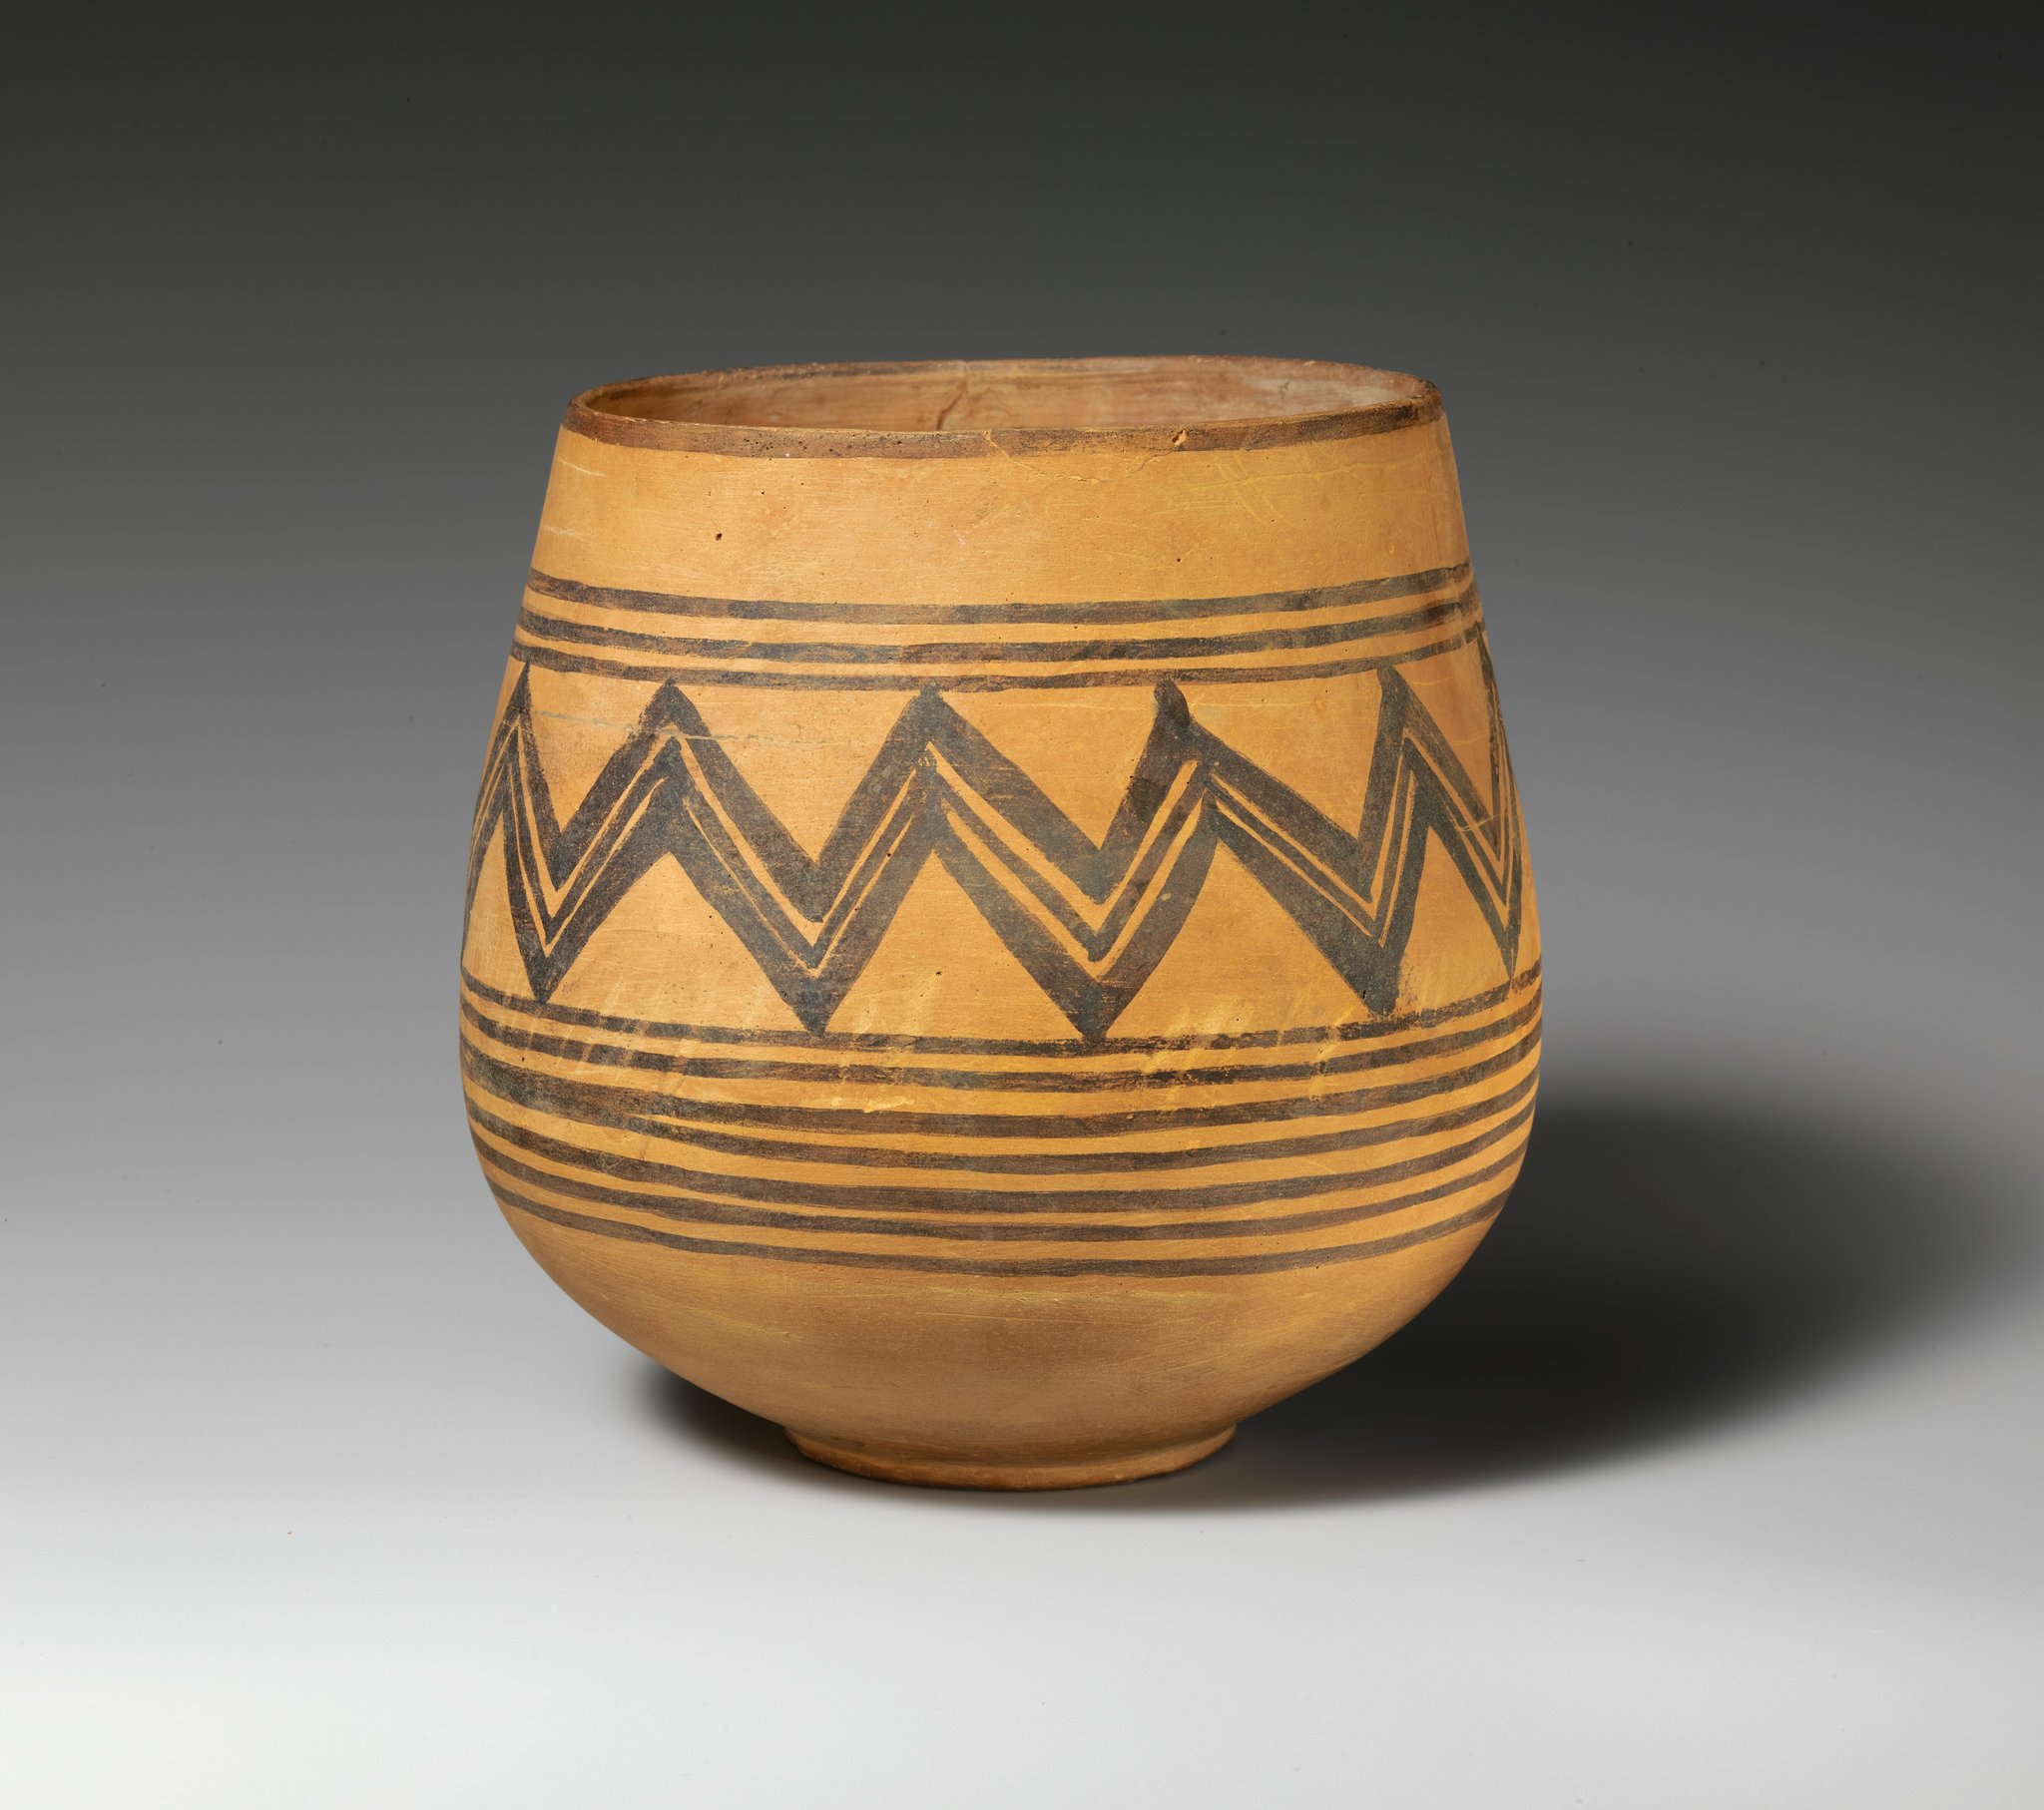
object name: bowl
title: Bowl with painted decoration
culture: indus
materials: ceramic, paint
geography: indus region